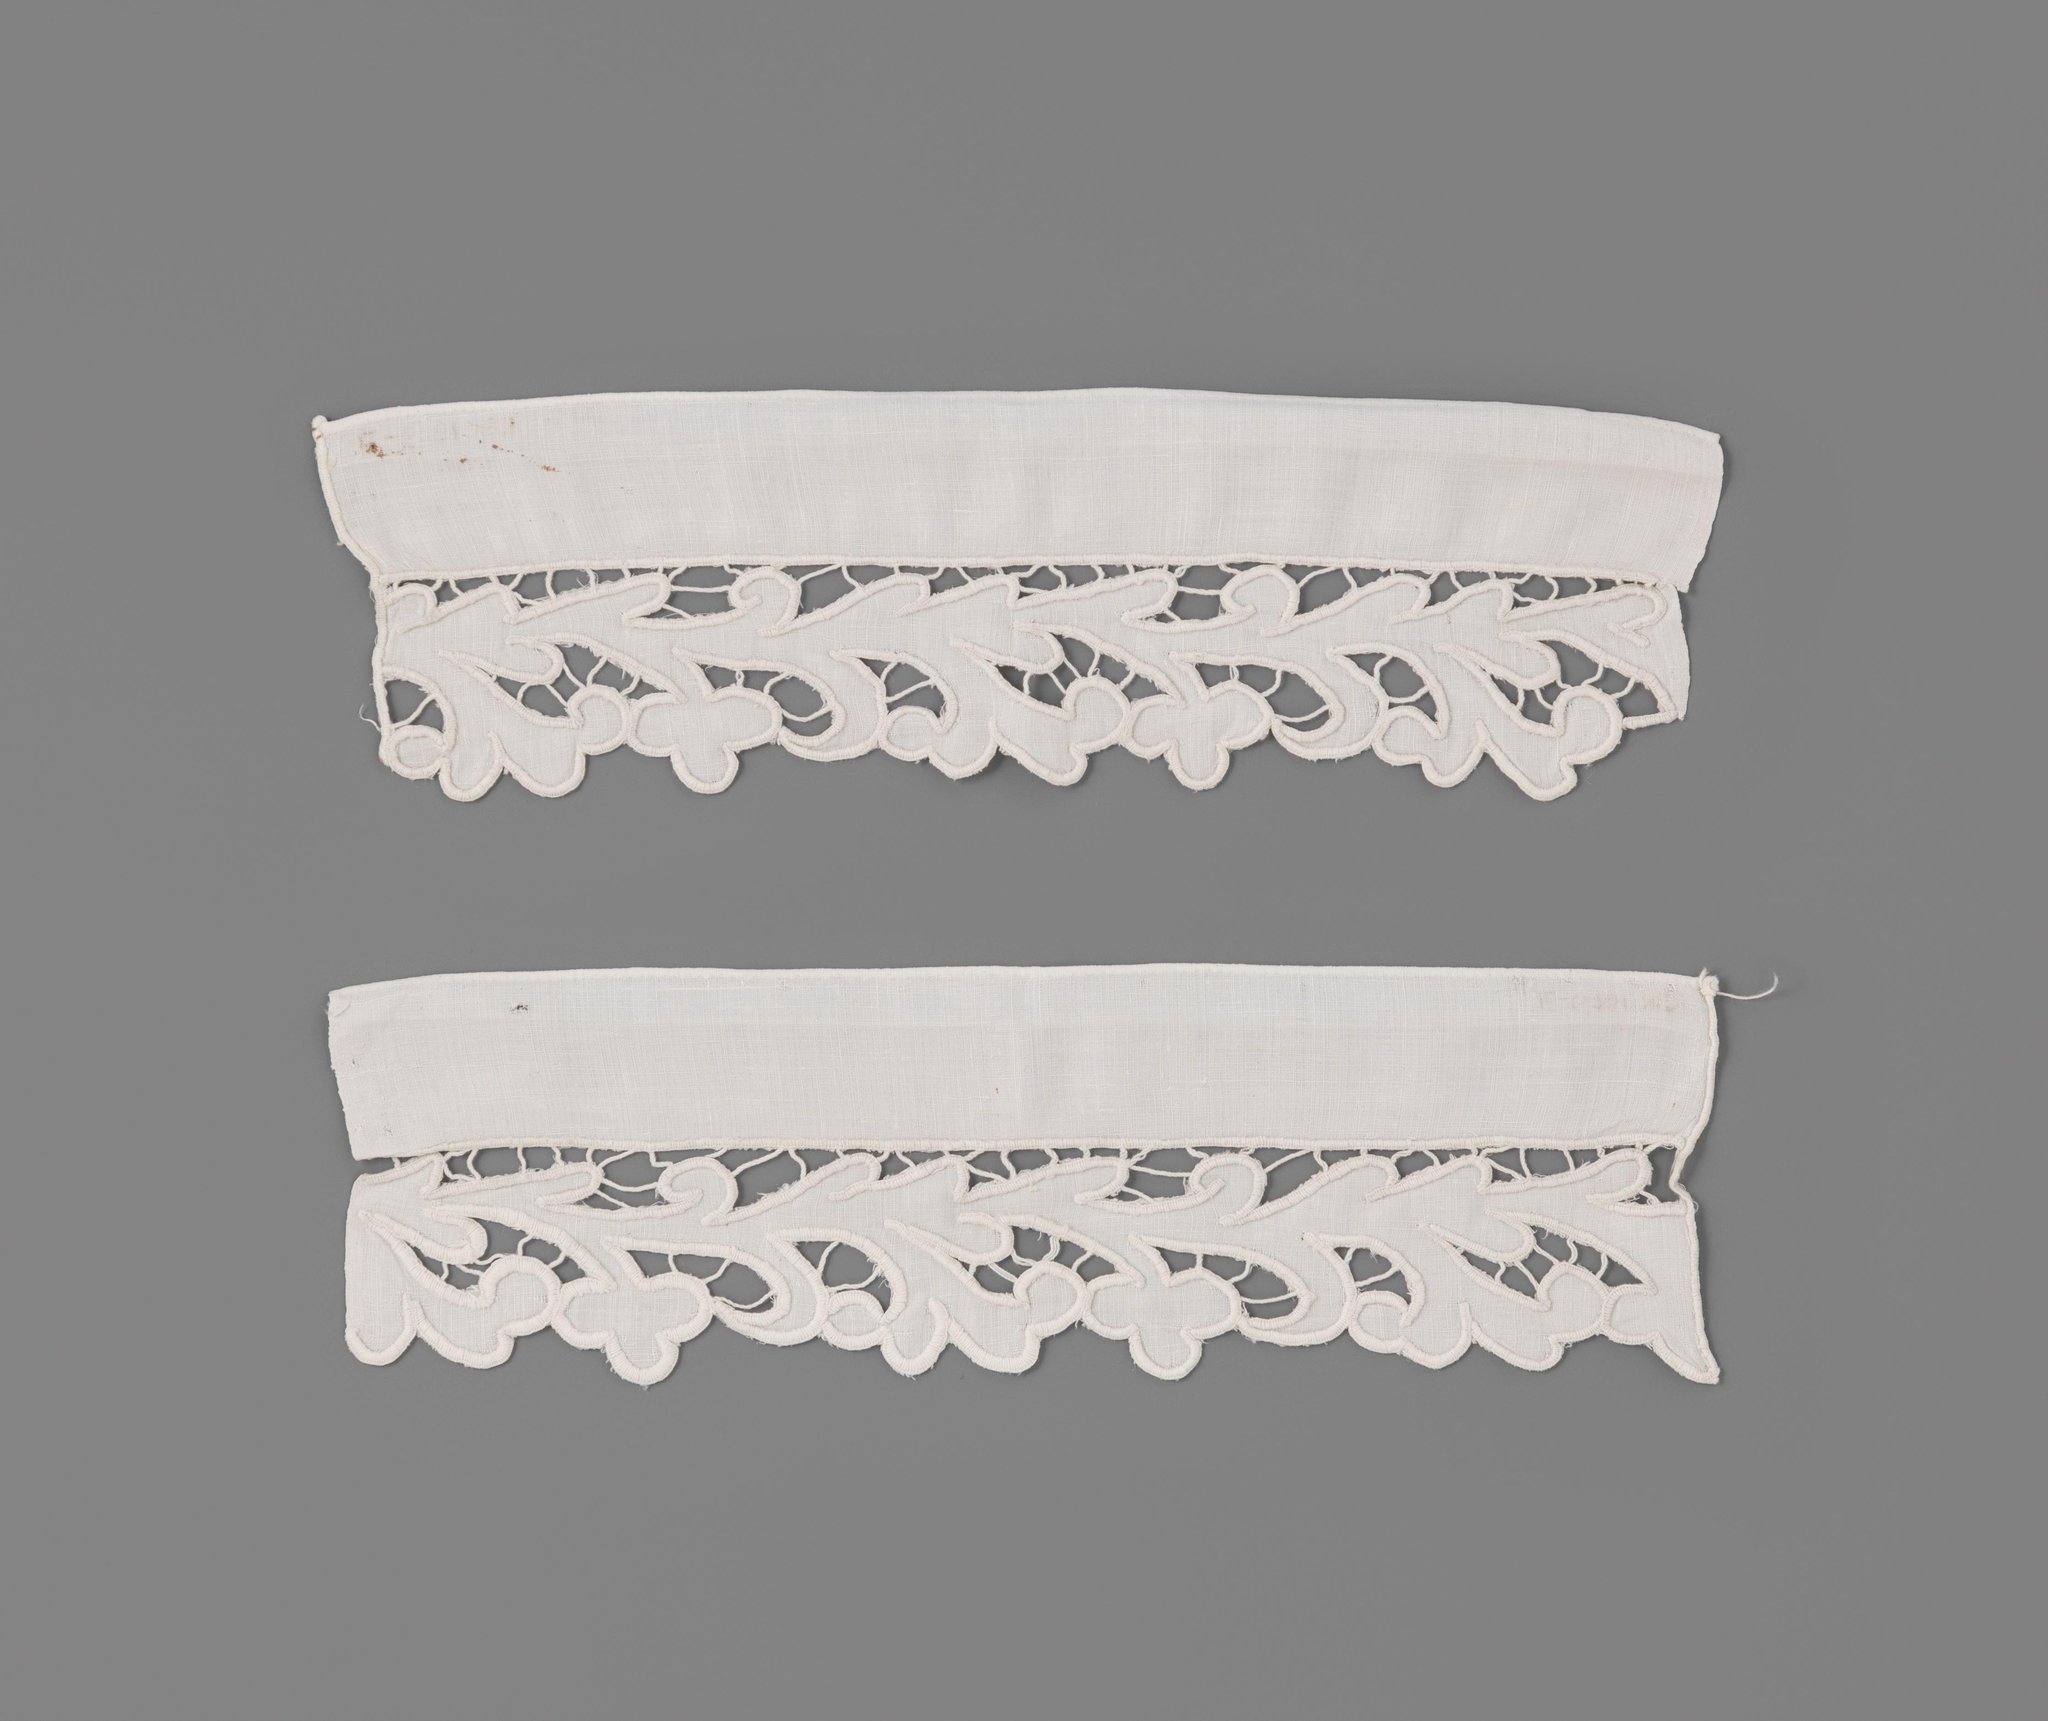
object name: cuff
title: Manchet van linnen met Richelieuwerk, met een lopend patroon van uitschuivende bladvormen met voluutvertakkingen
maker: Anonymous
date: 1920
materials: linen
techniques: richelieu work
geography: western europe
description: Manchetten van linnen met Richelien-borduursel. Techniek. Festoncontouren. Wijde gaten met spijlen gevuld. Model. Rechte strook effen stof, waaraan een bredere borduurstrook. Patroon. Lopend patroon van uitschuivende bladvormen, met voluutvertakkingen, die naar de buitenzijde breder zijn dan naar de binnenzijde.